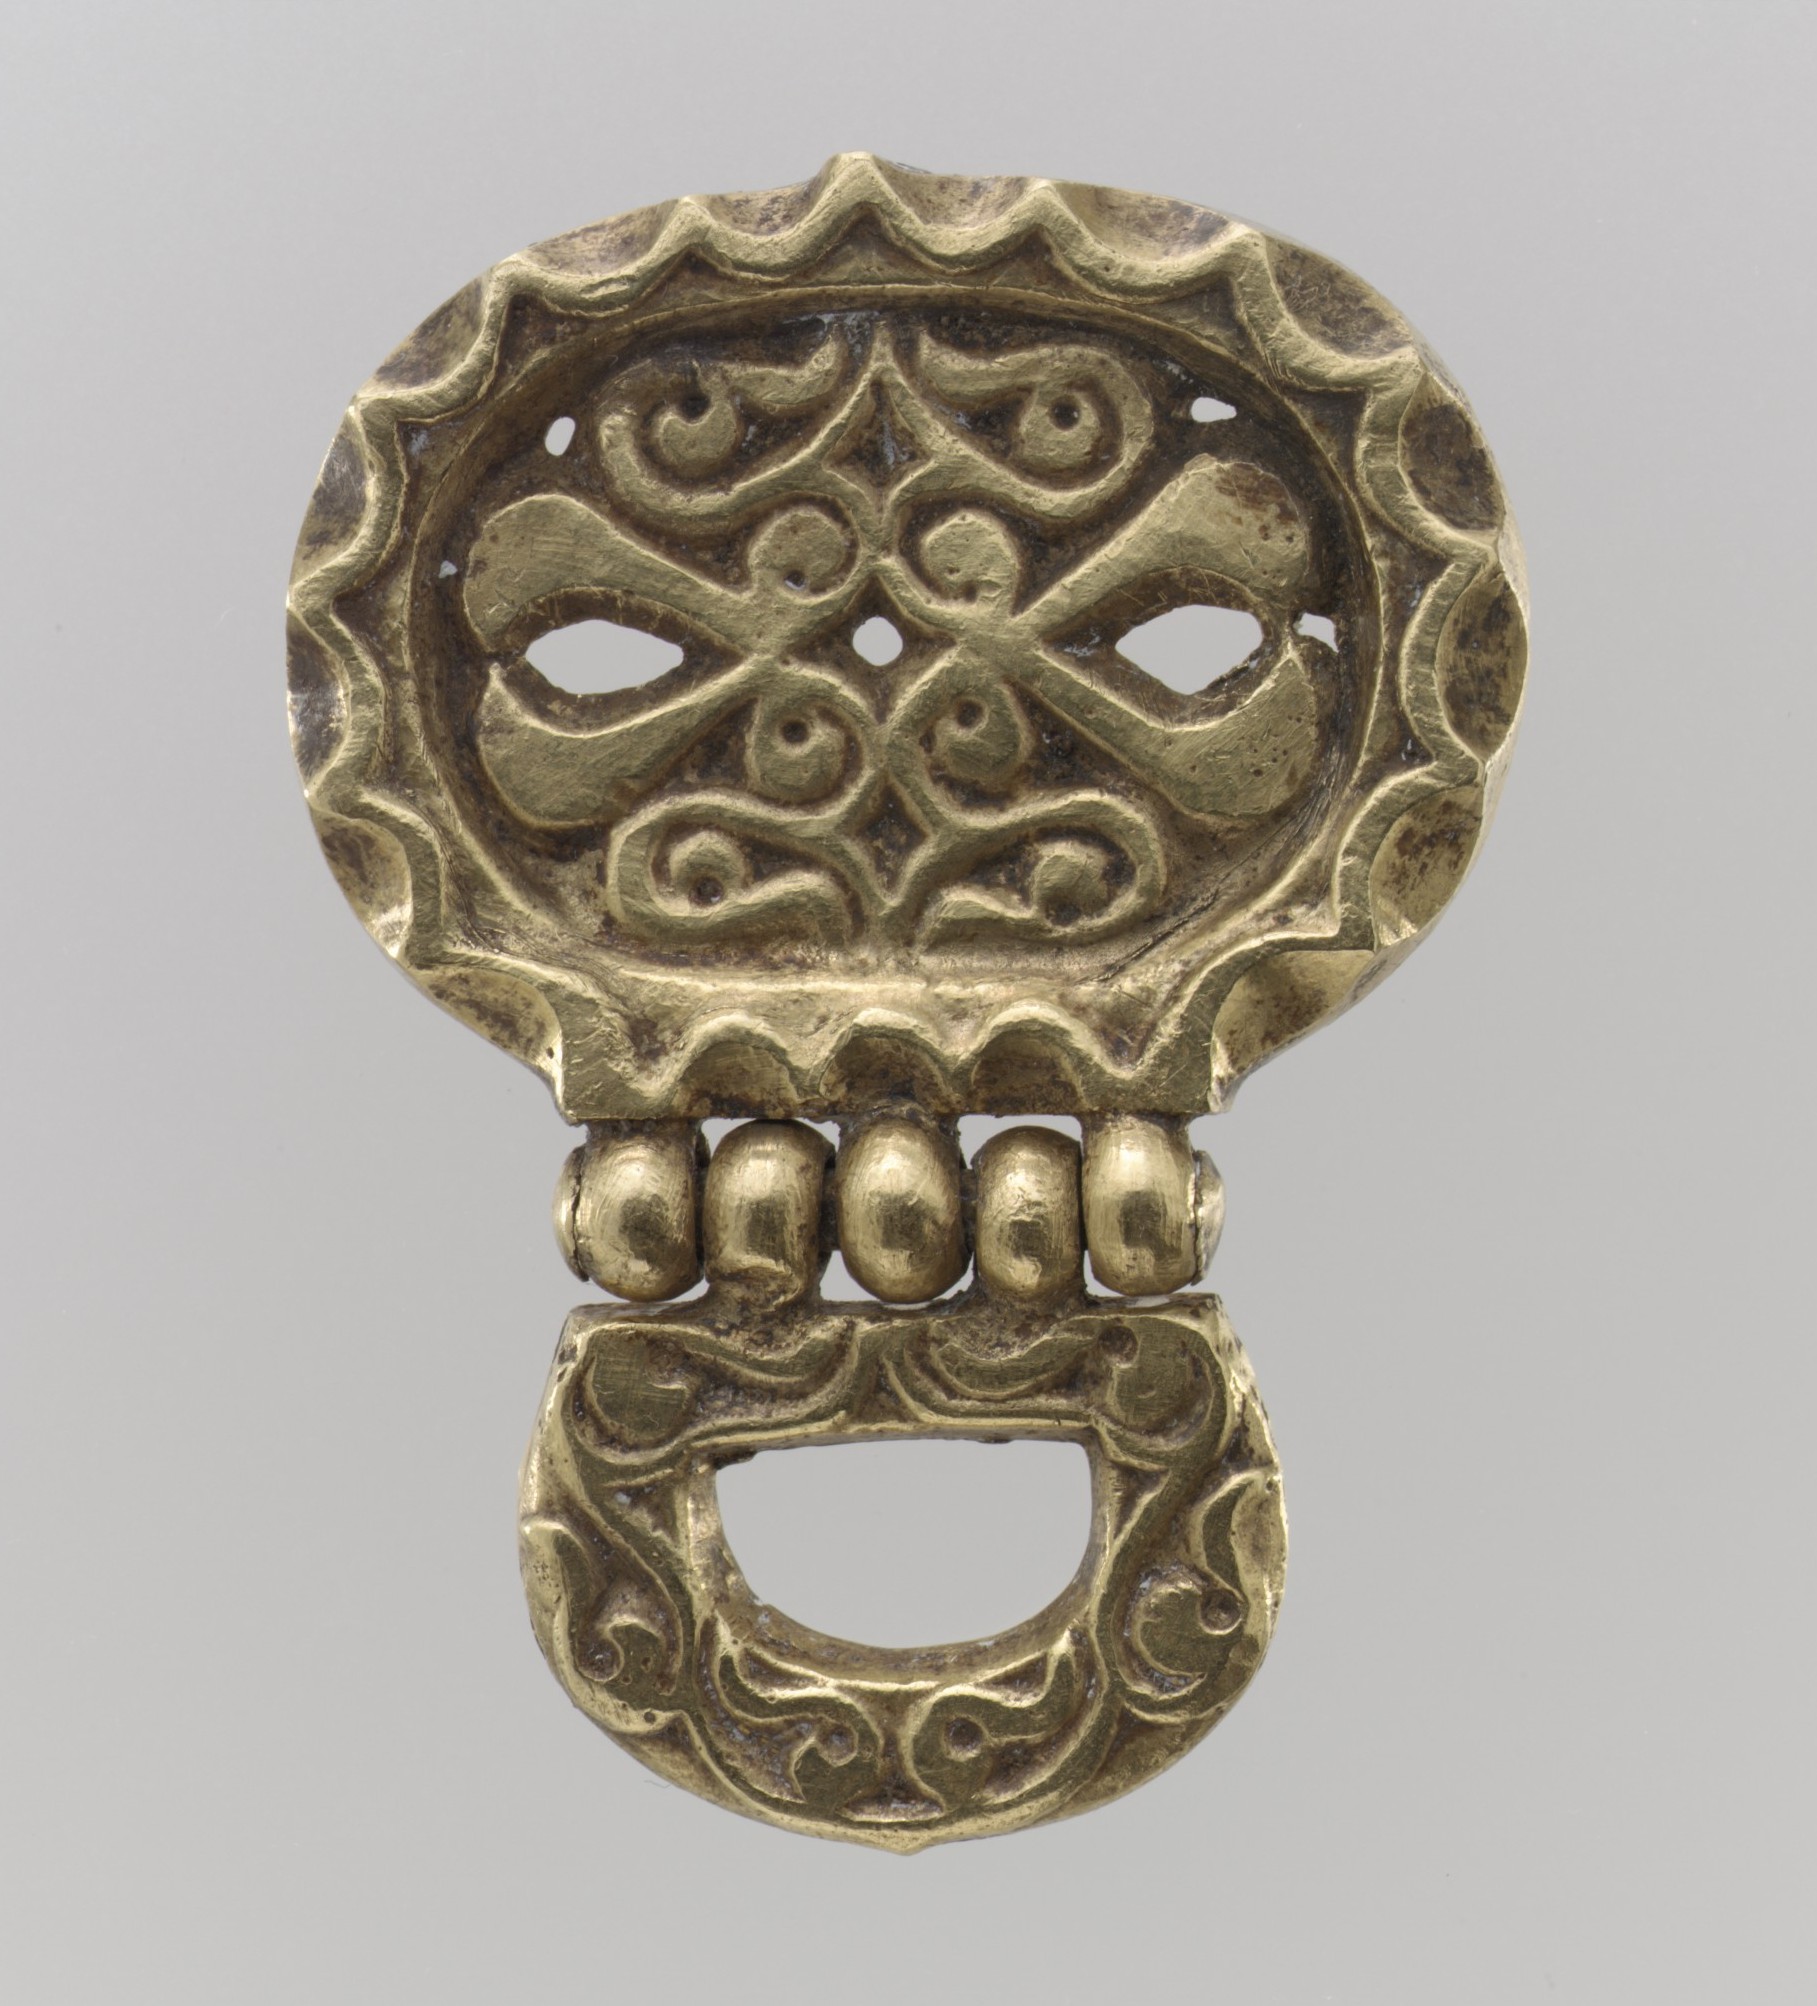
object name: belt mount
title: Gold Belt Mount with Loop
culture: avar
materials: gold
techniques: casting